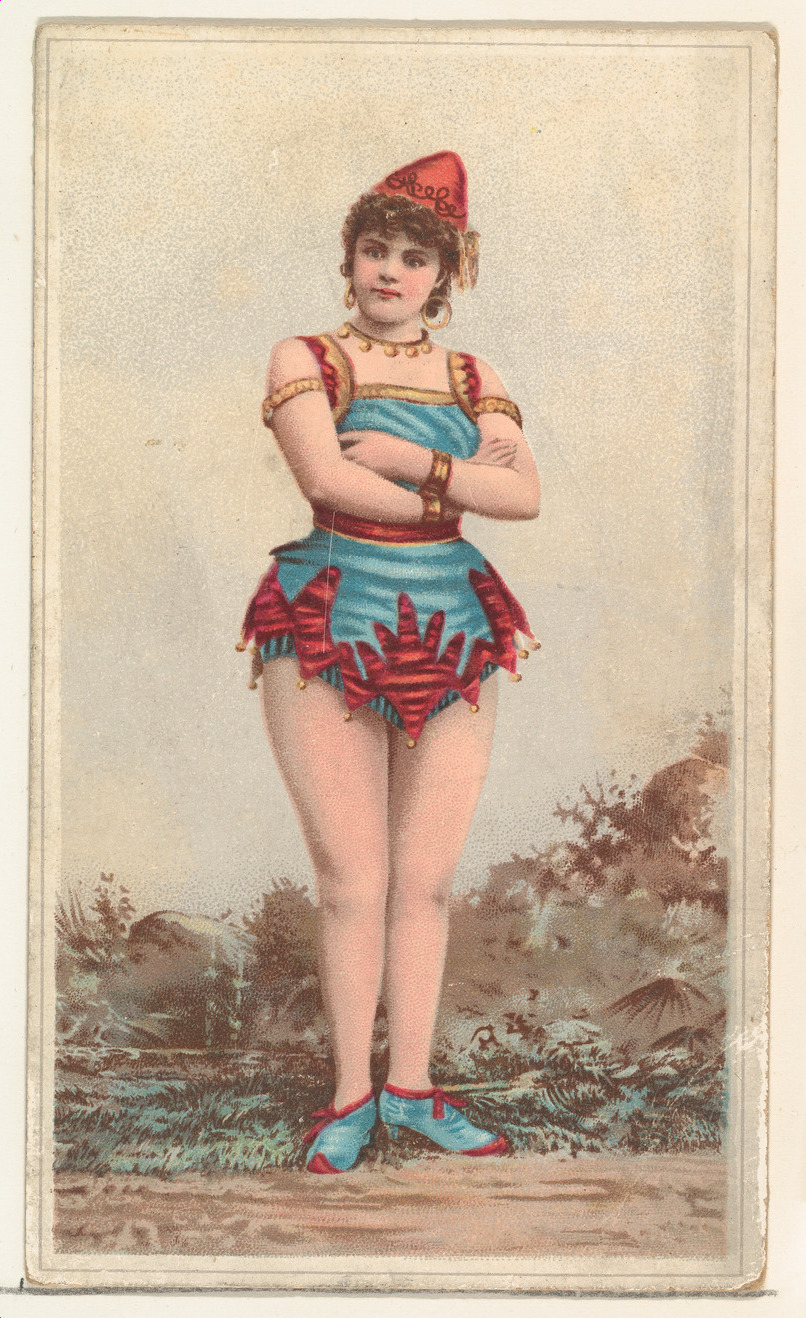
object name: print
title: Actress wearing red pointed cap, from Stars of the Stage, Second Series (N130) issued by Duke Sons & Co. to promote Honest Long Cut Tobacco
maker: w. duke, sons & co.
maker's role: publisher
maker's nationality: american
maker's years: 1870-1920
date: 1891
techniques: color lithograph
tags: portraits,women,actresses